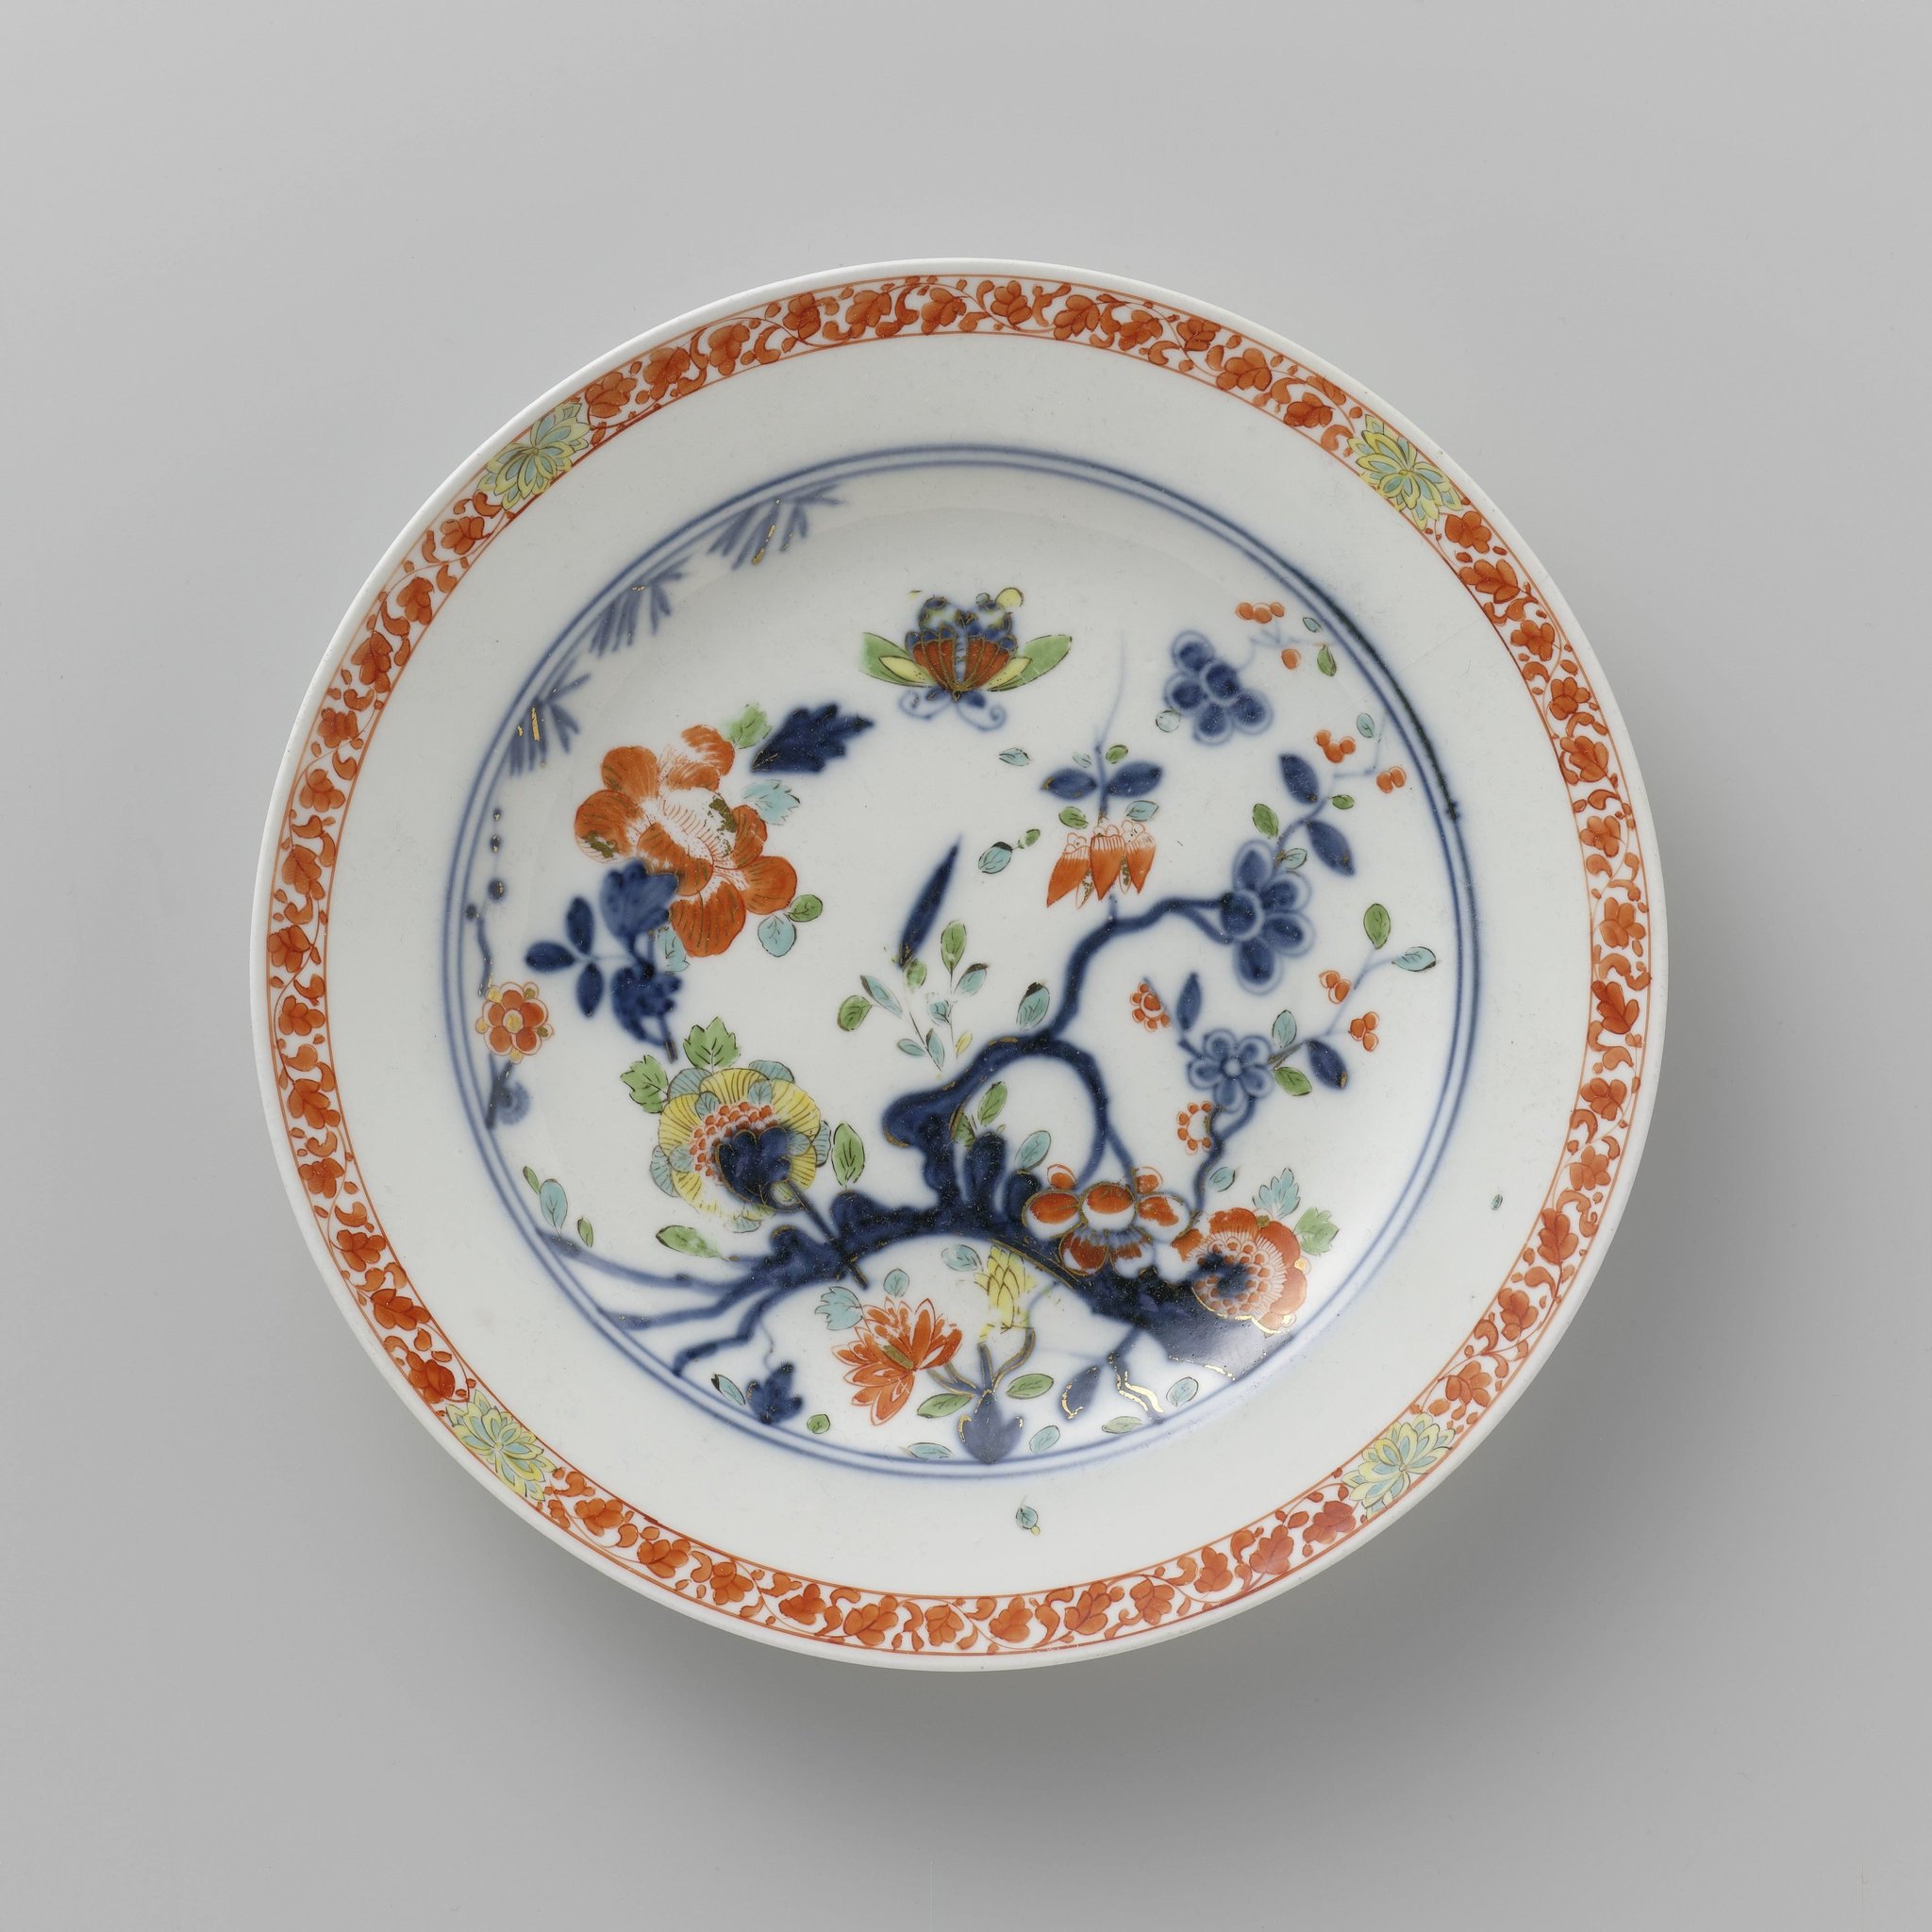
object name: plate dish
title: Bord, veelkleurig beschilderd met Indianische Blumen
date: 1730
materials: porcelain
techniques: painted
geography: meissen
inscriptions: factory mark, painter's mark: ‘K’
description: Plate. Porcelain. Meissen, c. 1730.